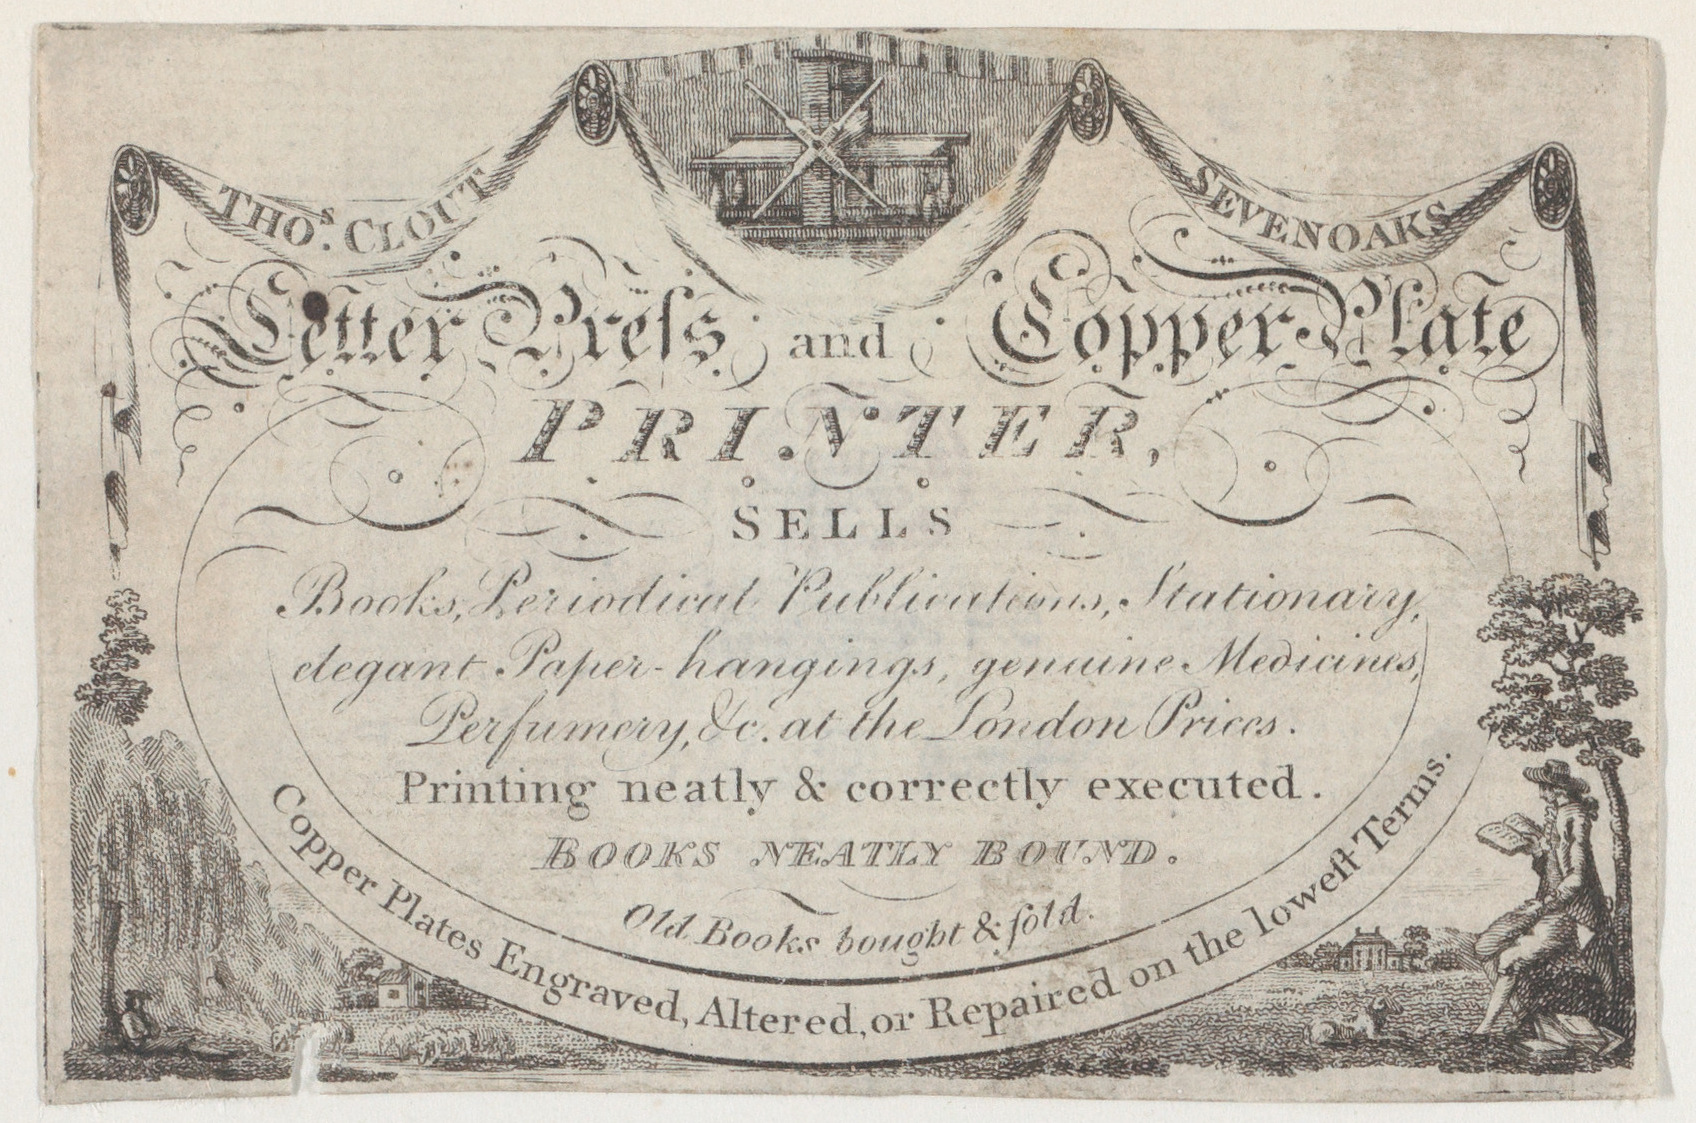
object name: print, trade card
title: Trade card for Thomas Clout, printer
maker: anonymous, british, 18th century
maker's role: artist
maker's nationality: british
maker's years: 1700-1800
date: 1701-1800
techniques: engraving